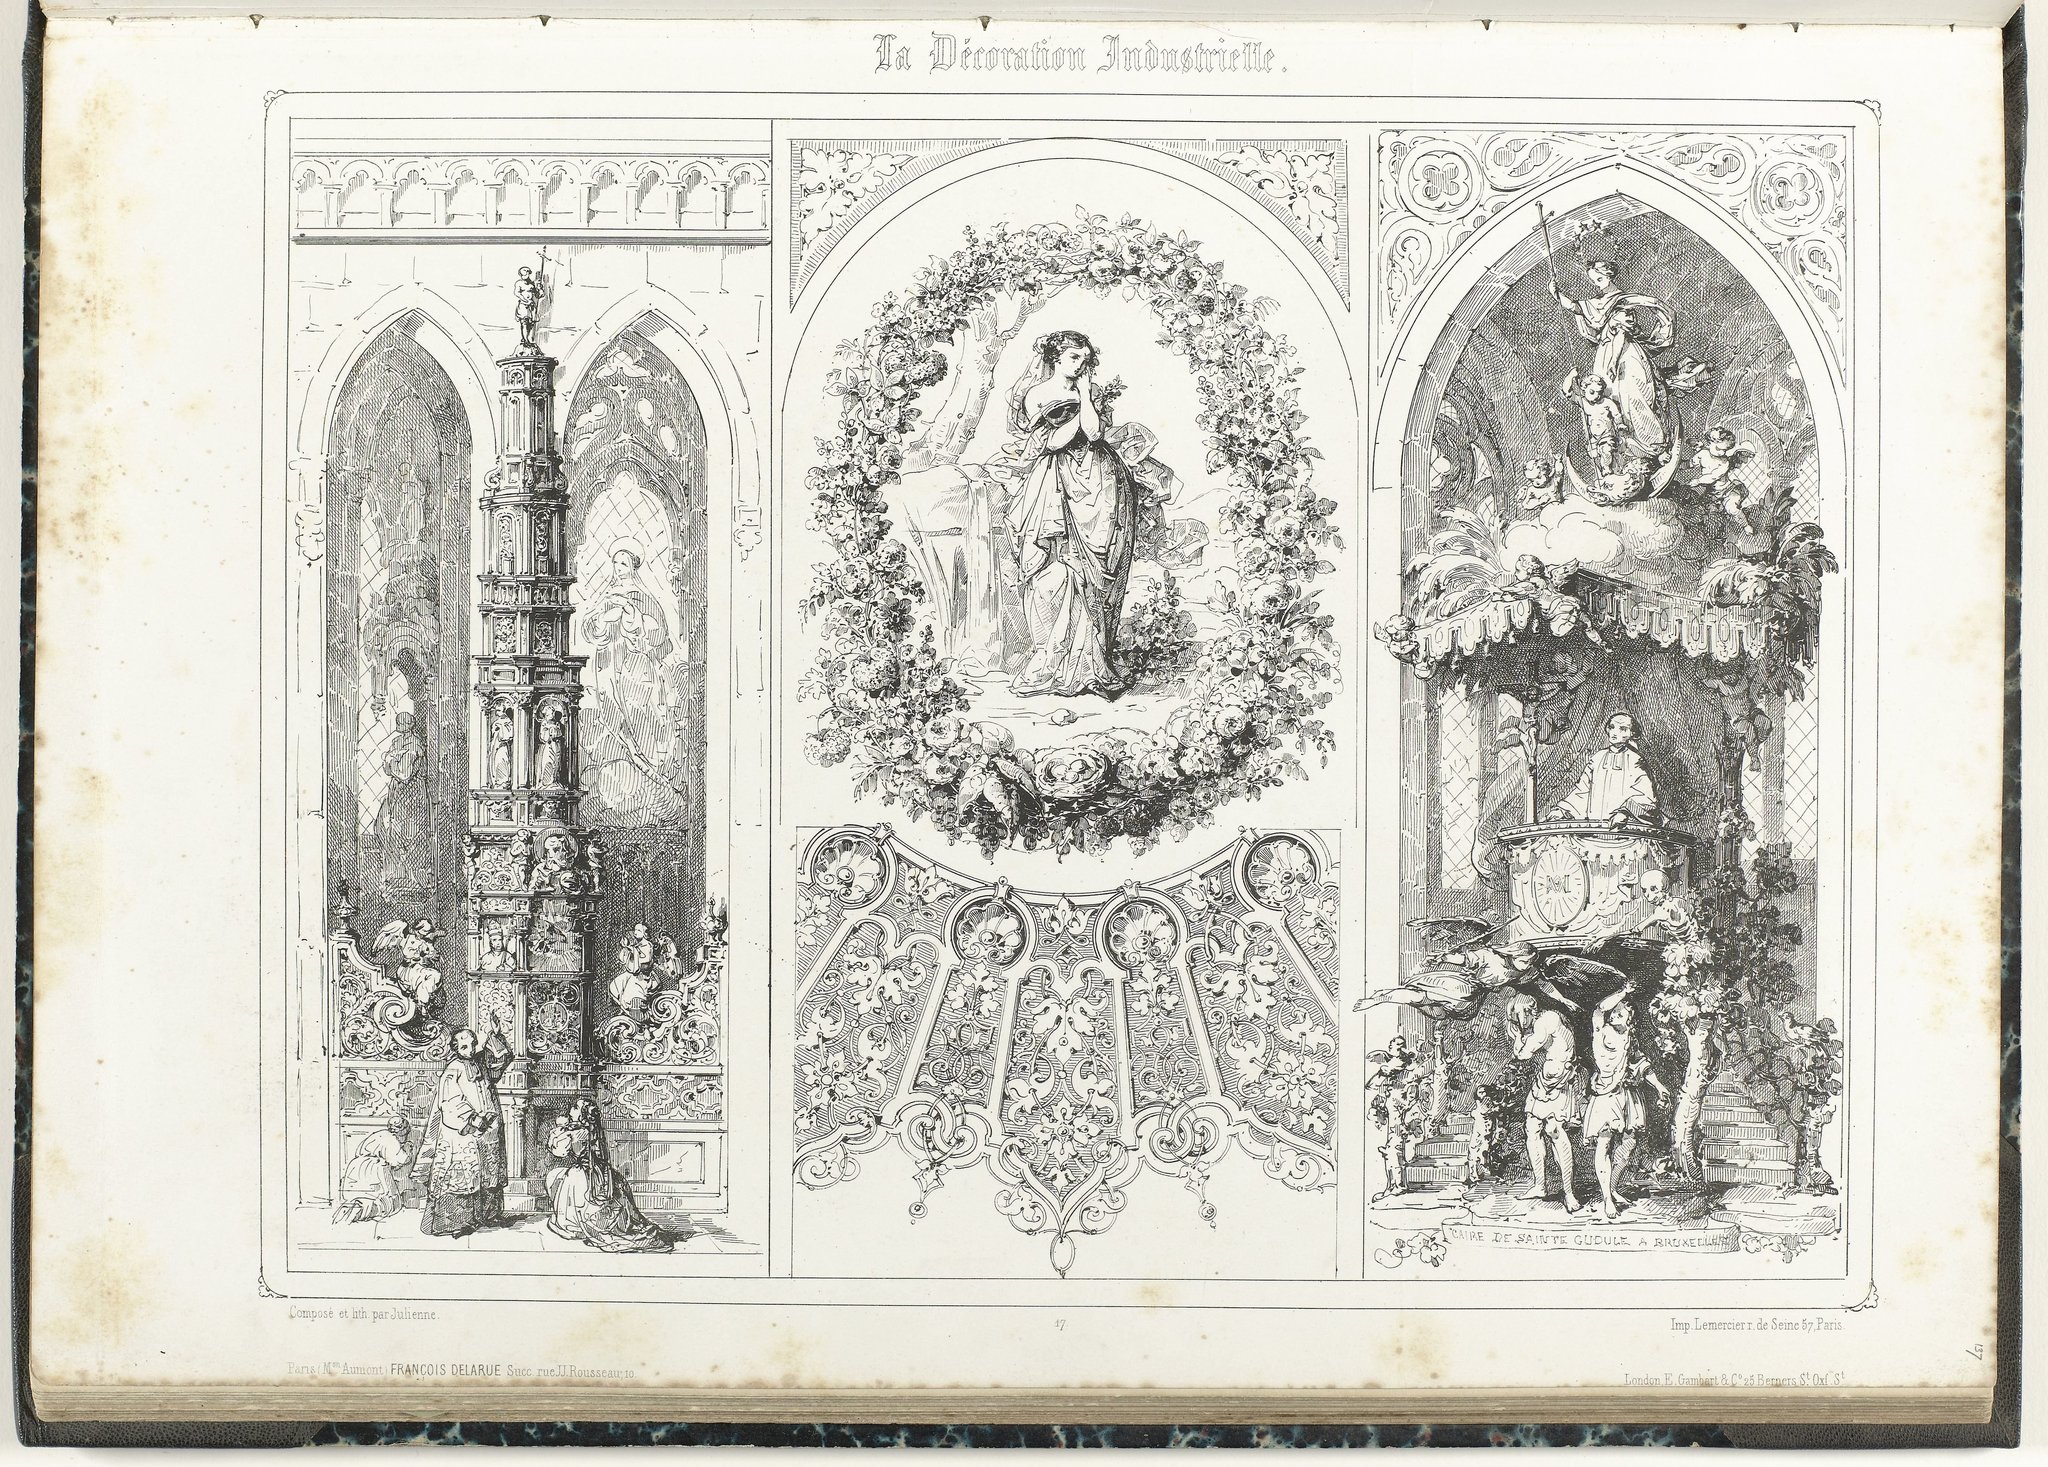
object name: print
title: La Décoration Industrielle.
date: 1866-1900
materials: paper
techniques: lithograph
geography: paris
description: Drie omkaderde voorstellingen, in het midden staat een vrouw in een omlijsting van bloemen, rechts is een kansel te zien. Rechtsonder: 17.